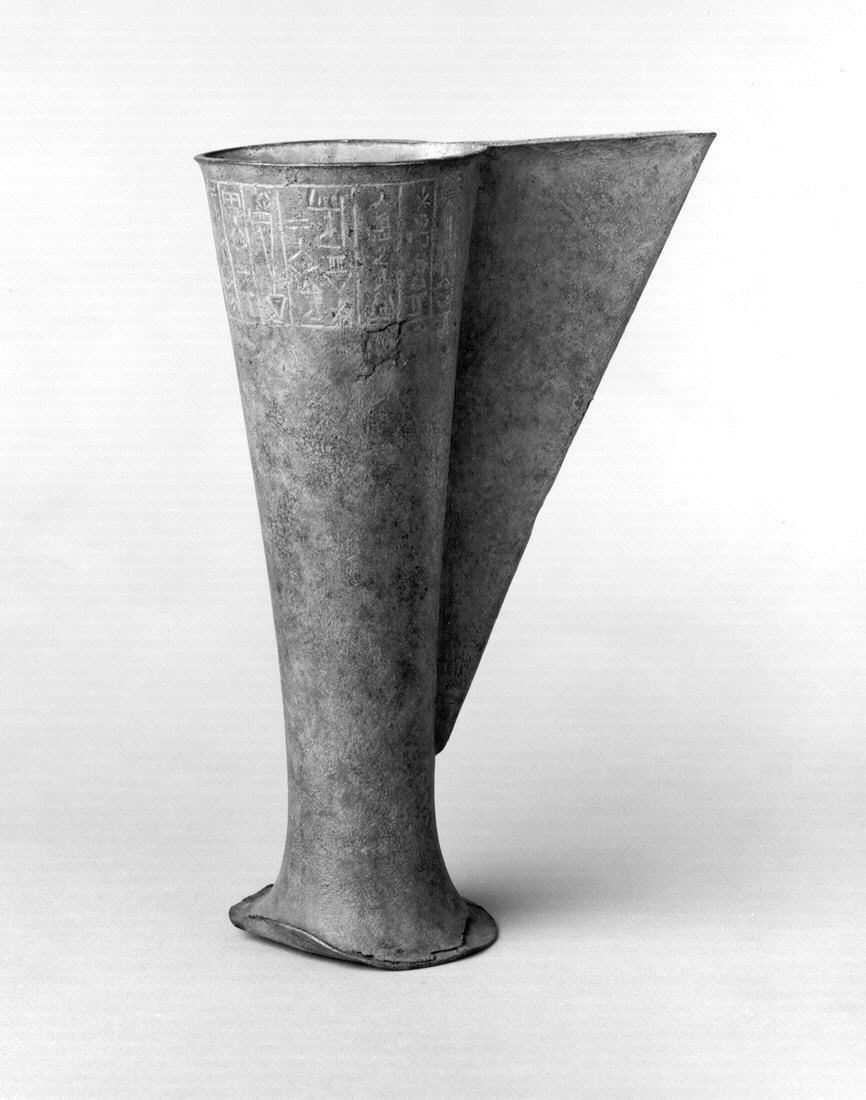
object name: vessel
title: Cult vessel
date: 2250-2000 BCE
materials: copper alloy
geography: northern mesopotamia